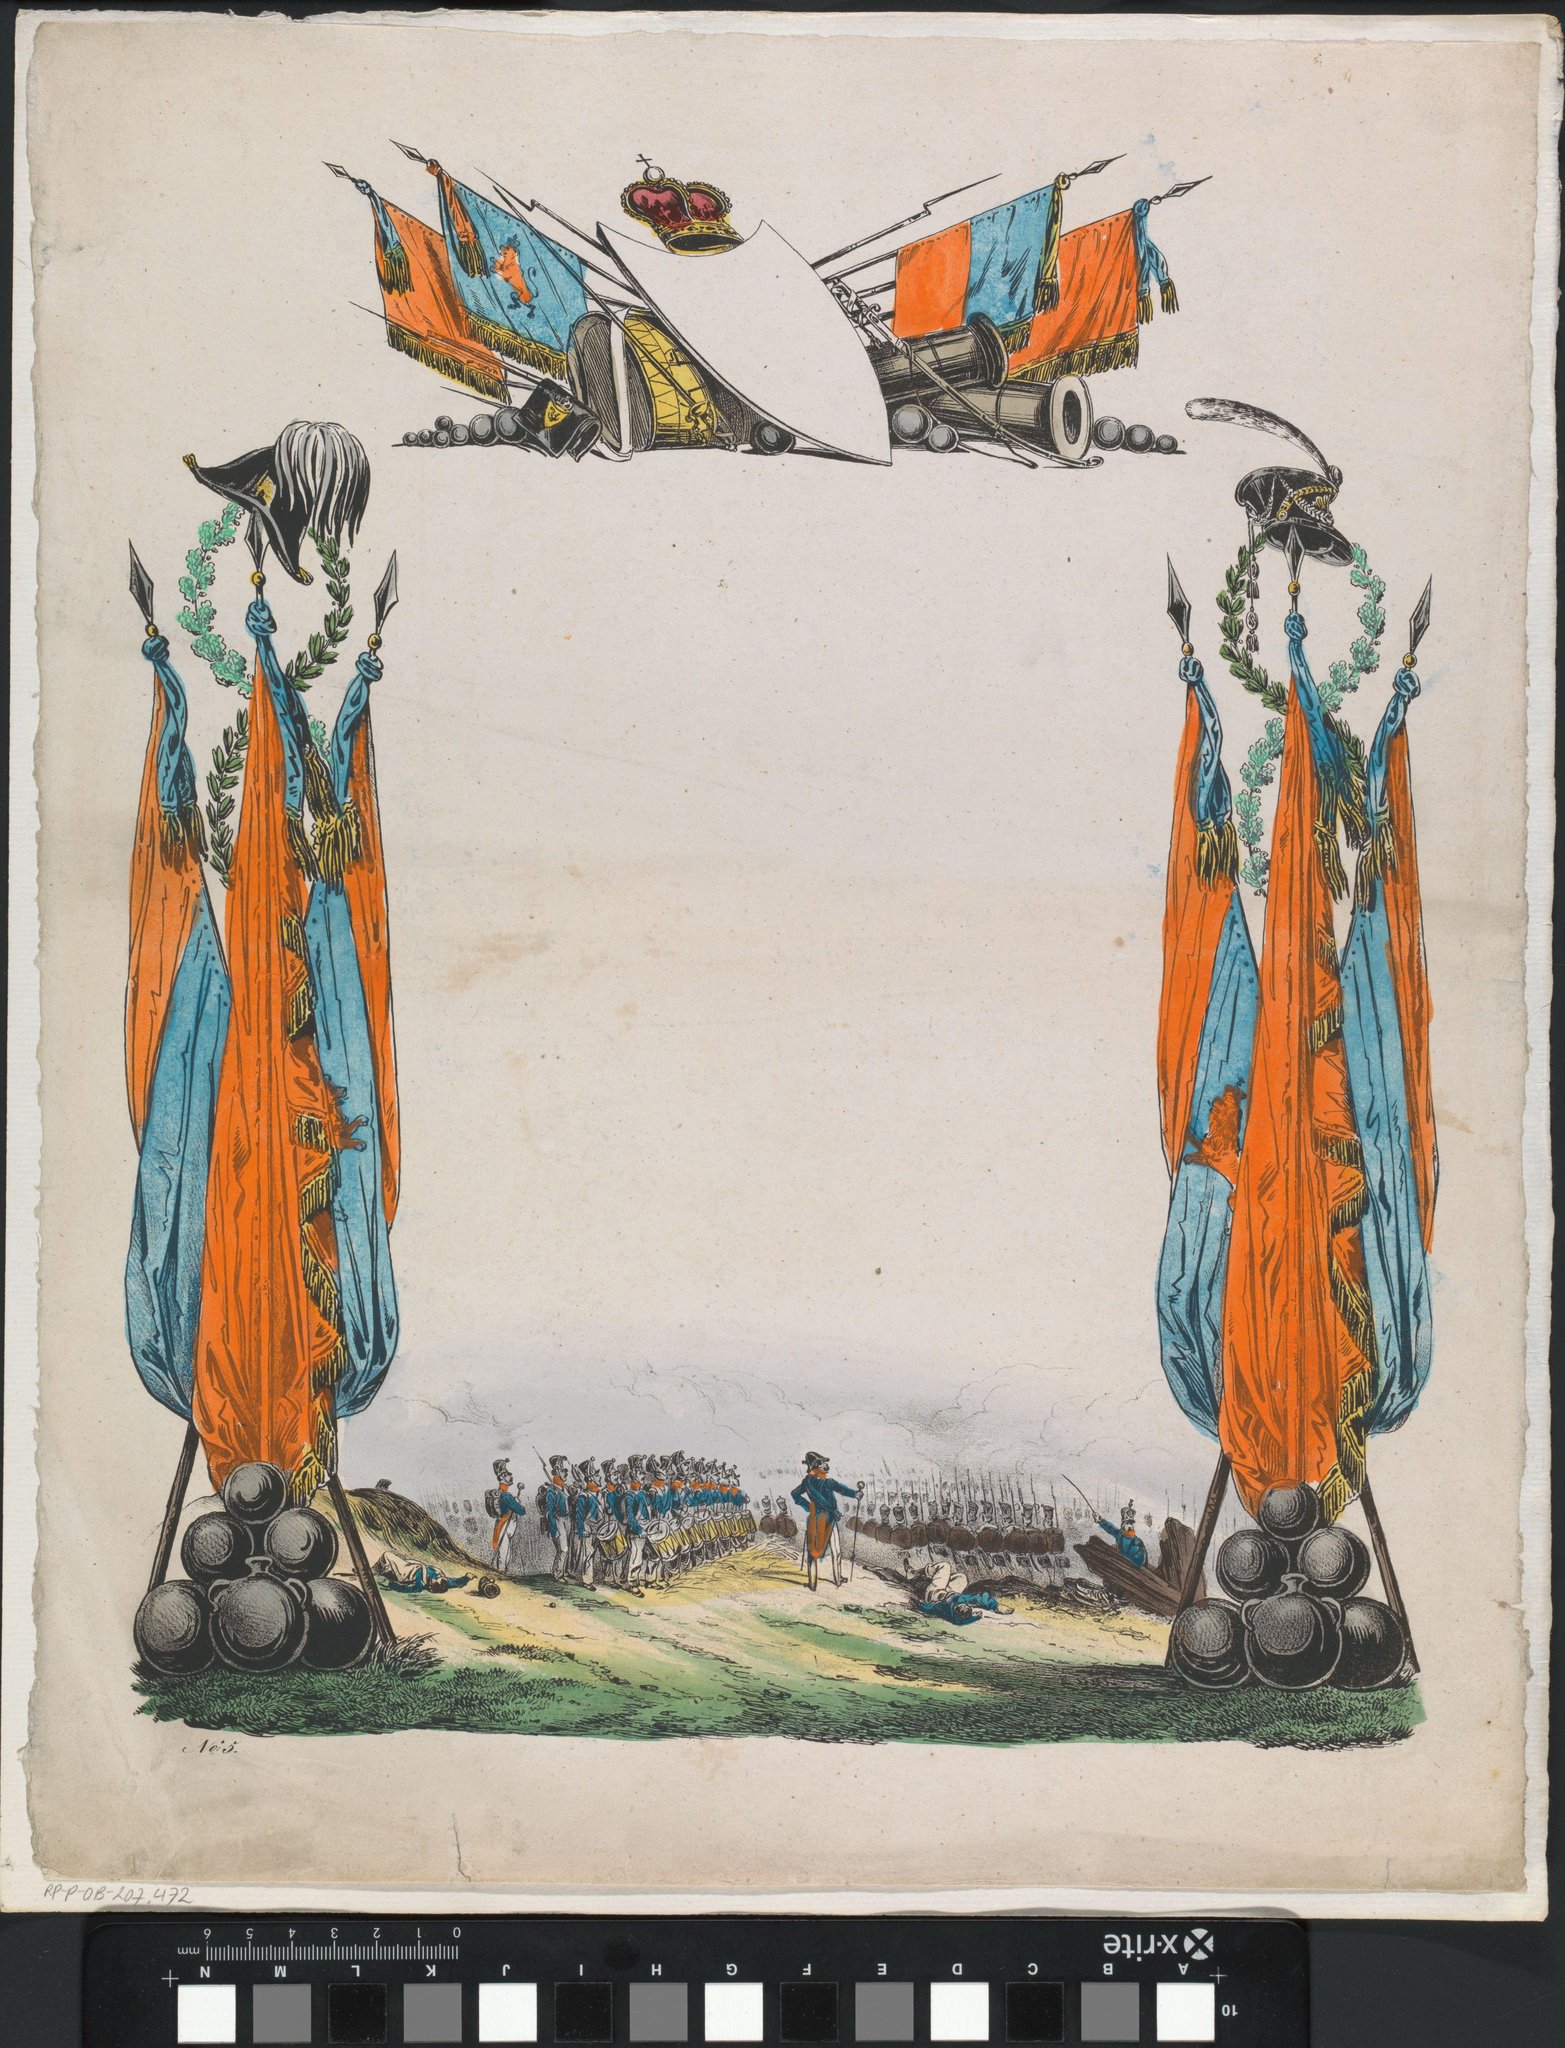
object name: popular print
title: Wensbrief met militairen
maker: Anonymous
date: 1780-1899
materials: paper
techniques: colour, lithograph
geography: netherlands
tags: land forces, firearms: cannon, the soldier; the soldier's life, (military) flags and standards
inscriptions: collector's mark: Lugt 2760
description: Wensbrief met onbeschreven cartouche binnen een decoratief kader met voorstellingen van een admiraal tussen twee legers, kanonnen, kanonskogels en vaandels. Genummerd linksonder: No. 5.